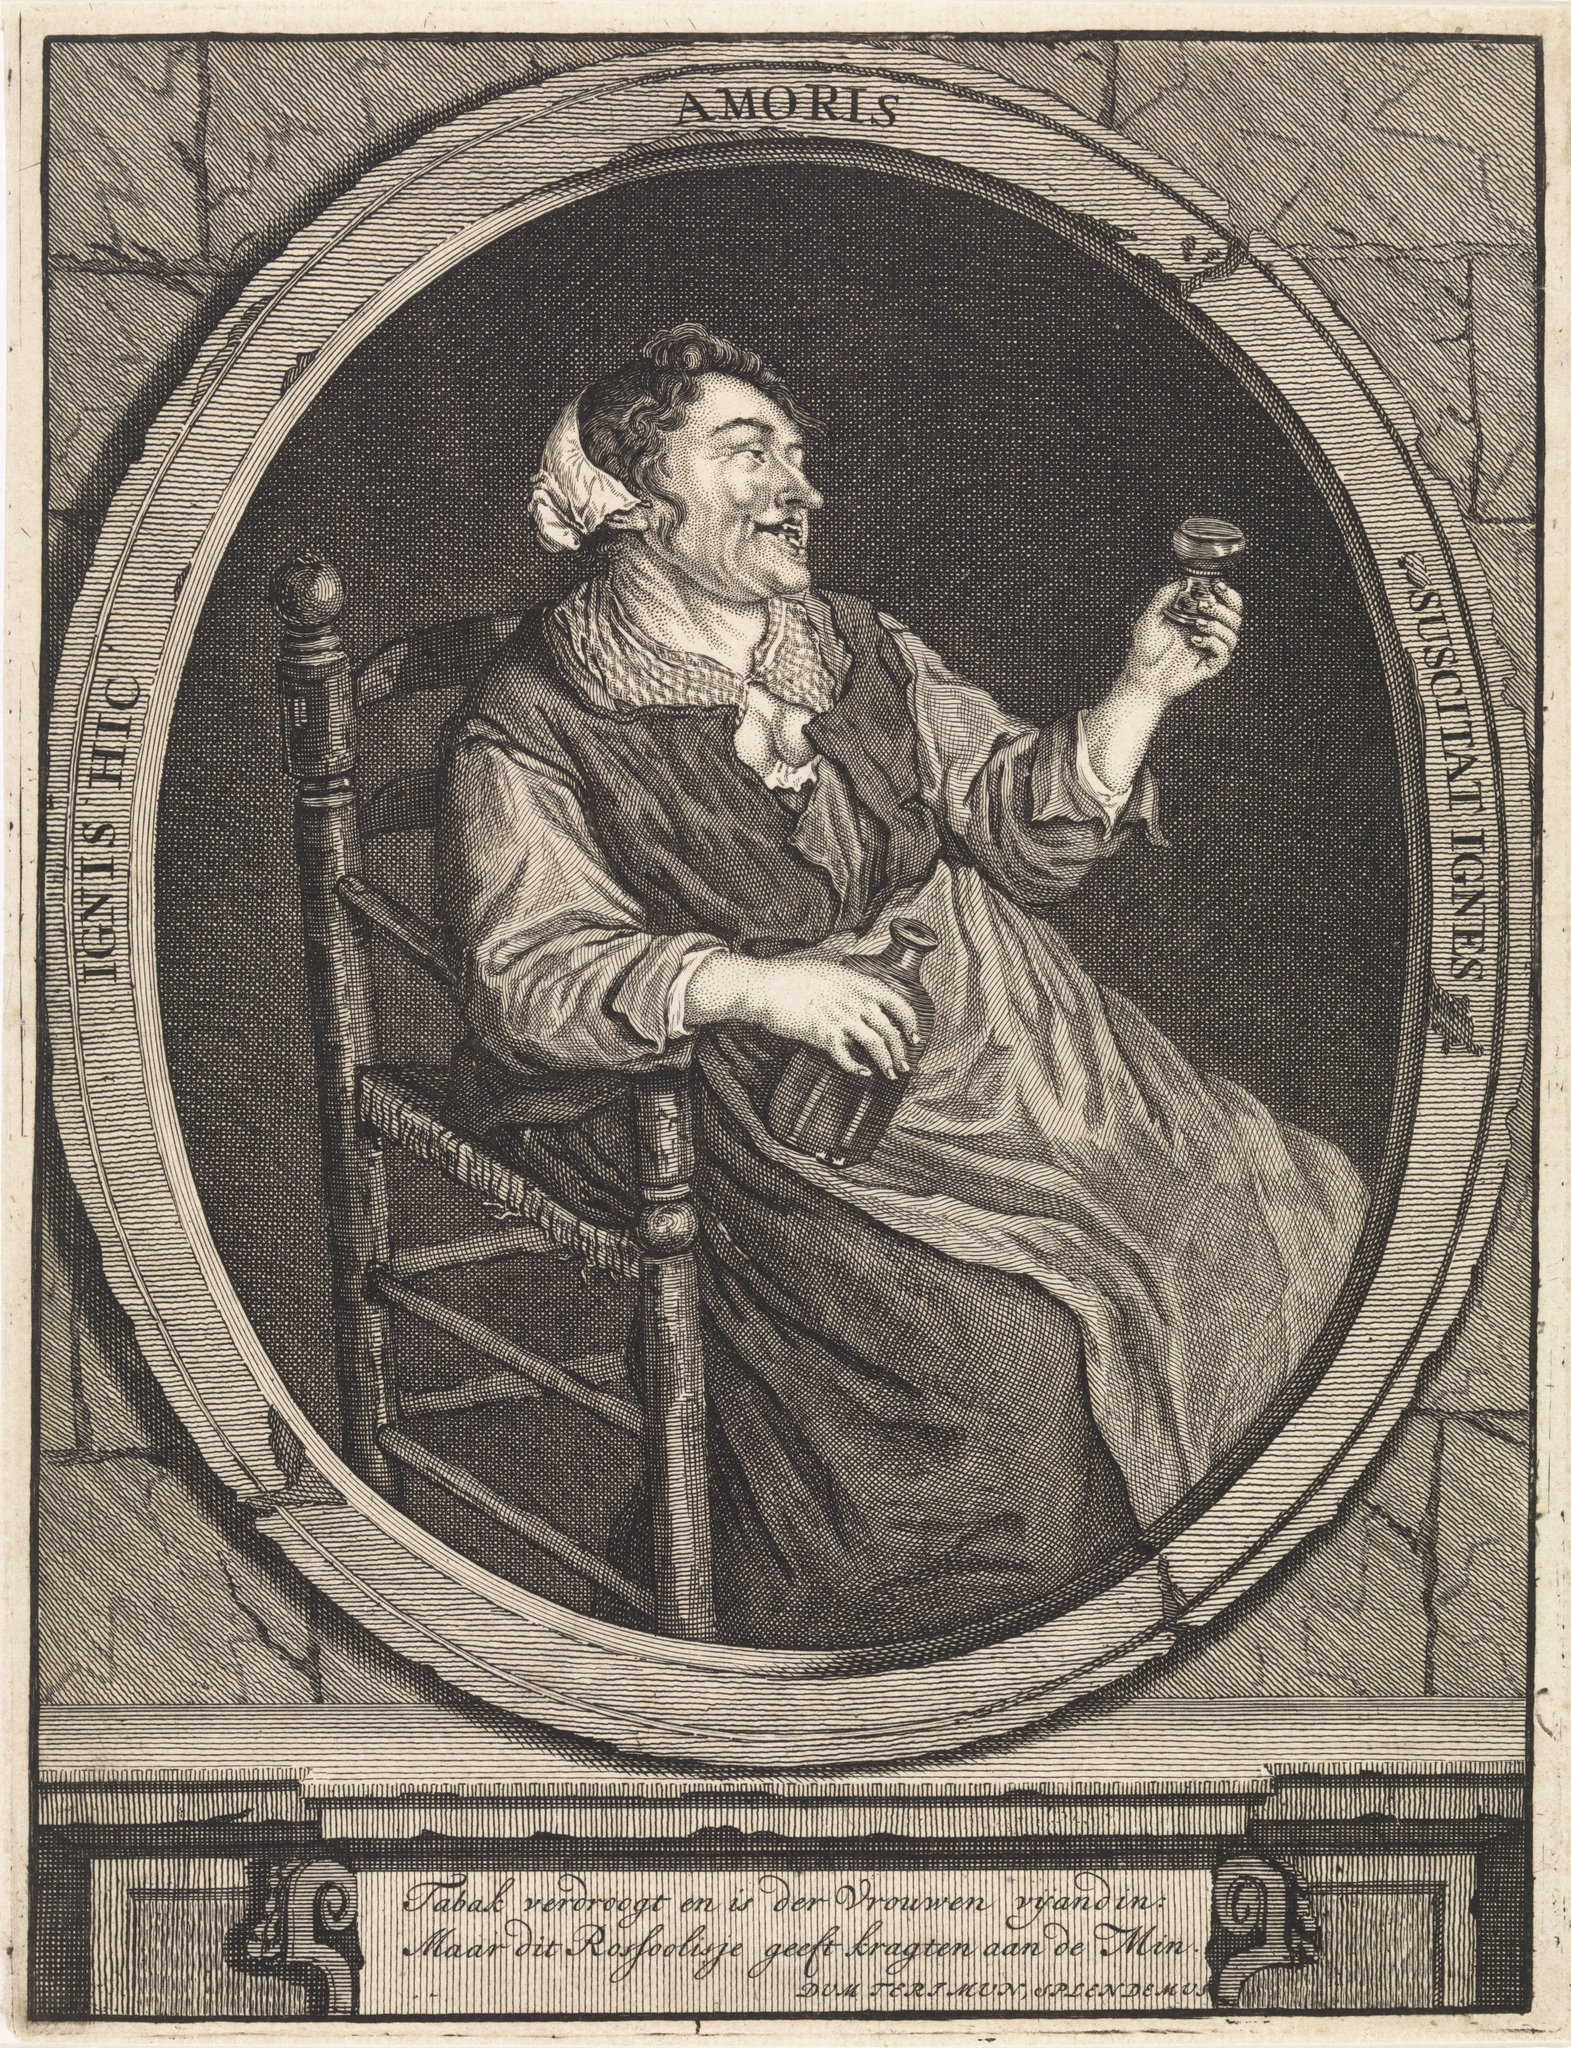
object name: print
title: Boerin met een roemer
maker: matthijs pool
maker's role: print maker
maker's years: 1676-1740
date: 1696-1727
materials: paper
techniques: engraving, etching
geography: amsterdam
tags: farmers, glass, rummer, alcoholic drinks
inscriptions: collector's mark: Lugt 2228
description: Een boerin zit op een stoel. In haar handen houdt ze een roemer en een fles drank. In het kader onder de voorstelling een spotgedicht.